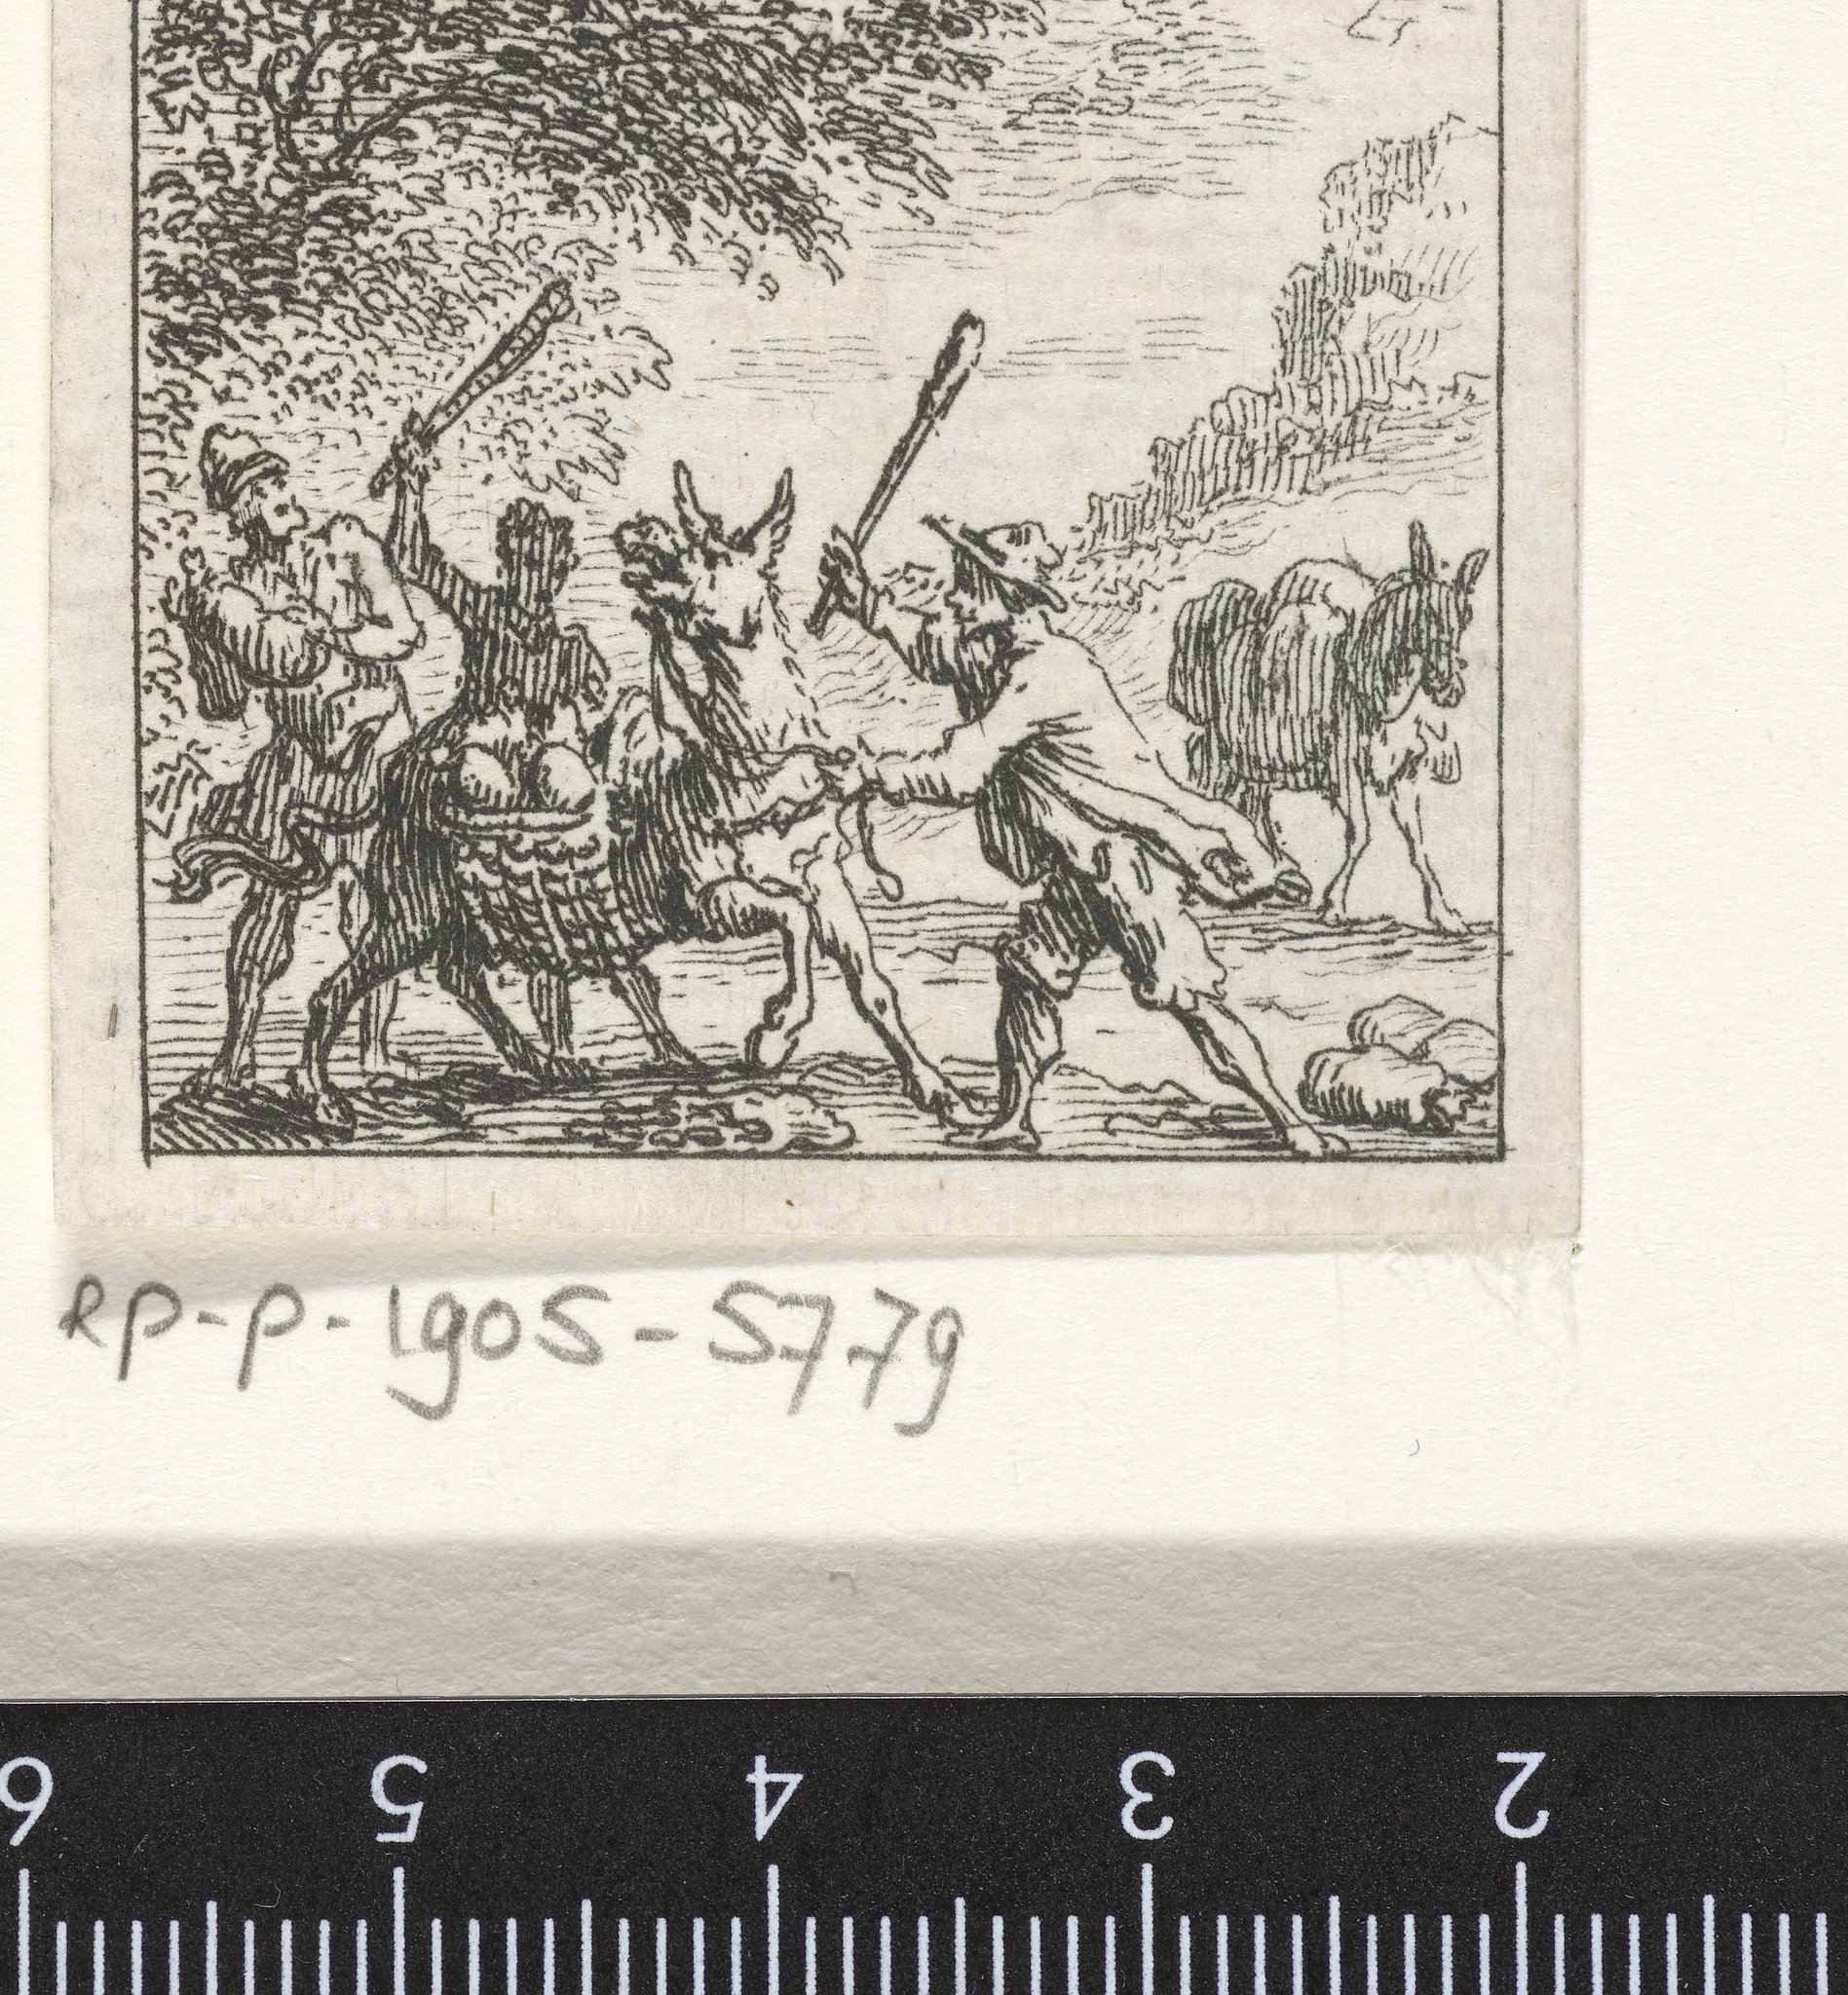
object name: book illustration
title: Illustraties voor fabelvertellingen van Phaedrus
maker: simon fokke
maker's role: draughtsman, print maker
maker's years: 1712-1784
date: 1769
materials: paper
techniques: etching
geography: amsterdam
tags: fables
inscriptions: collector's mark: Lugt 2228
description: Struikrovers slaan een bepakte muilezel met stokken en stelen de goederen die het beest op zijn rug vervoert. Deze illustratie is vervaardigd bij de Aesopische fabels van de Latijnse dichter Phaedrus.